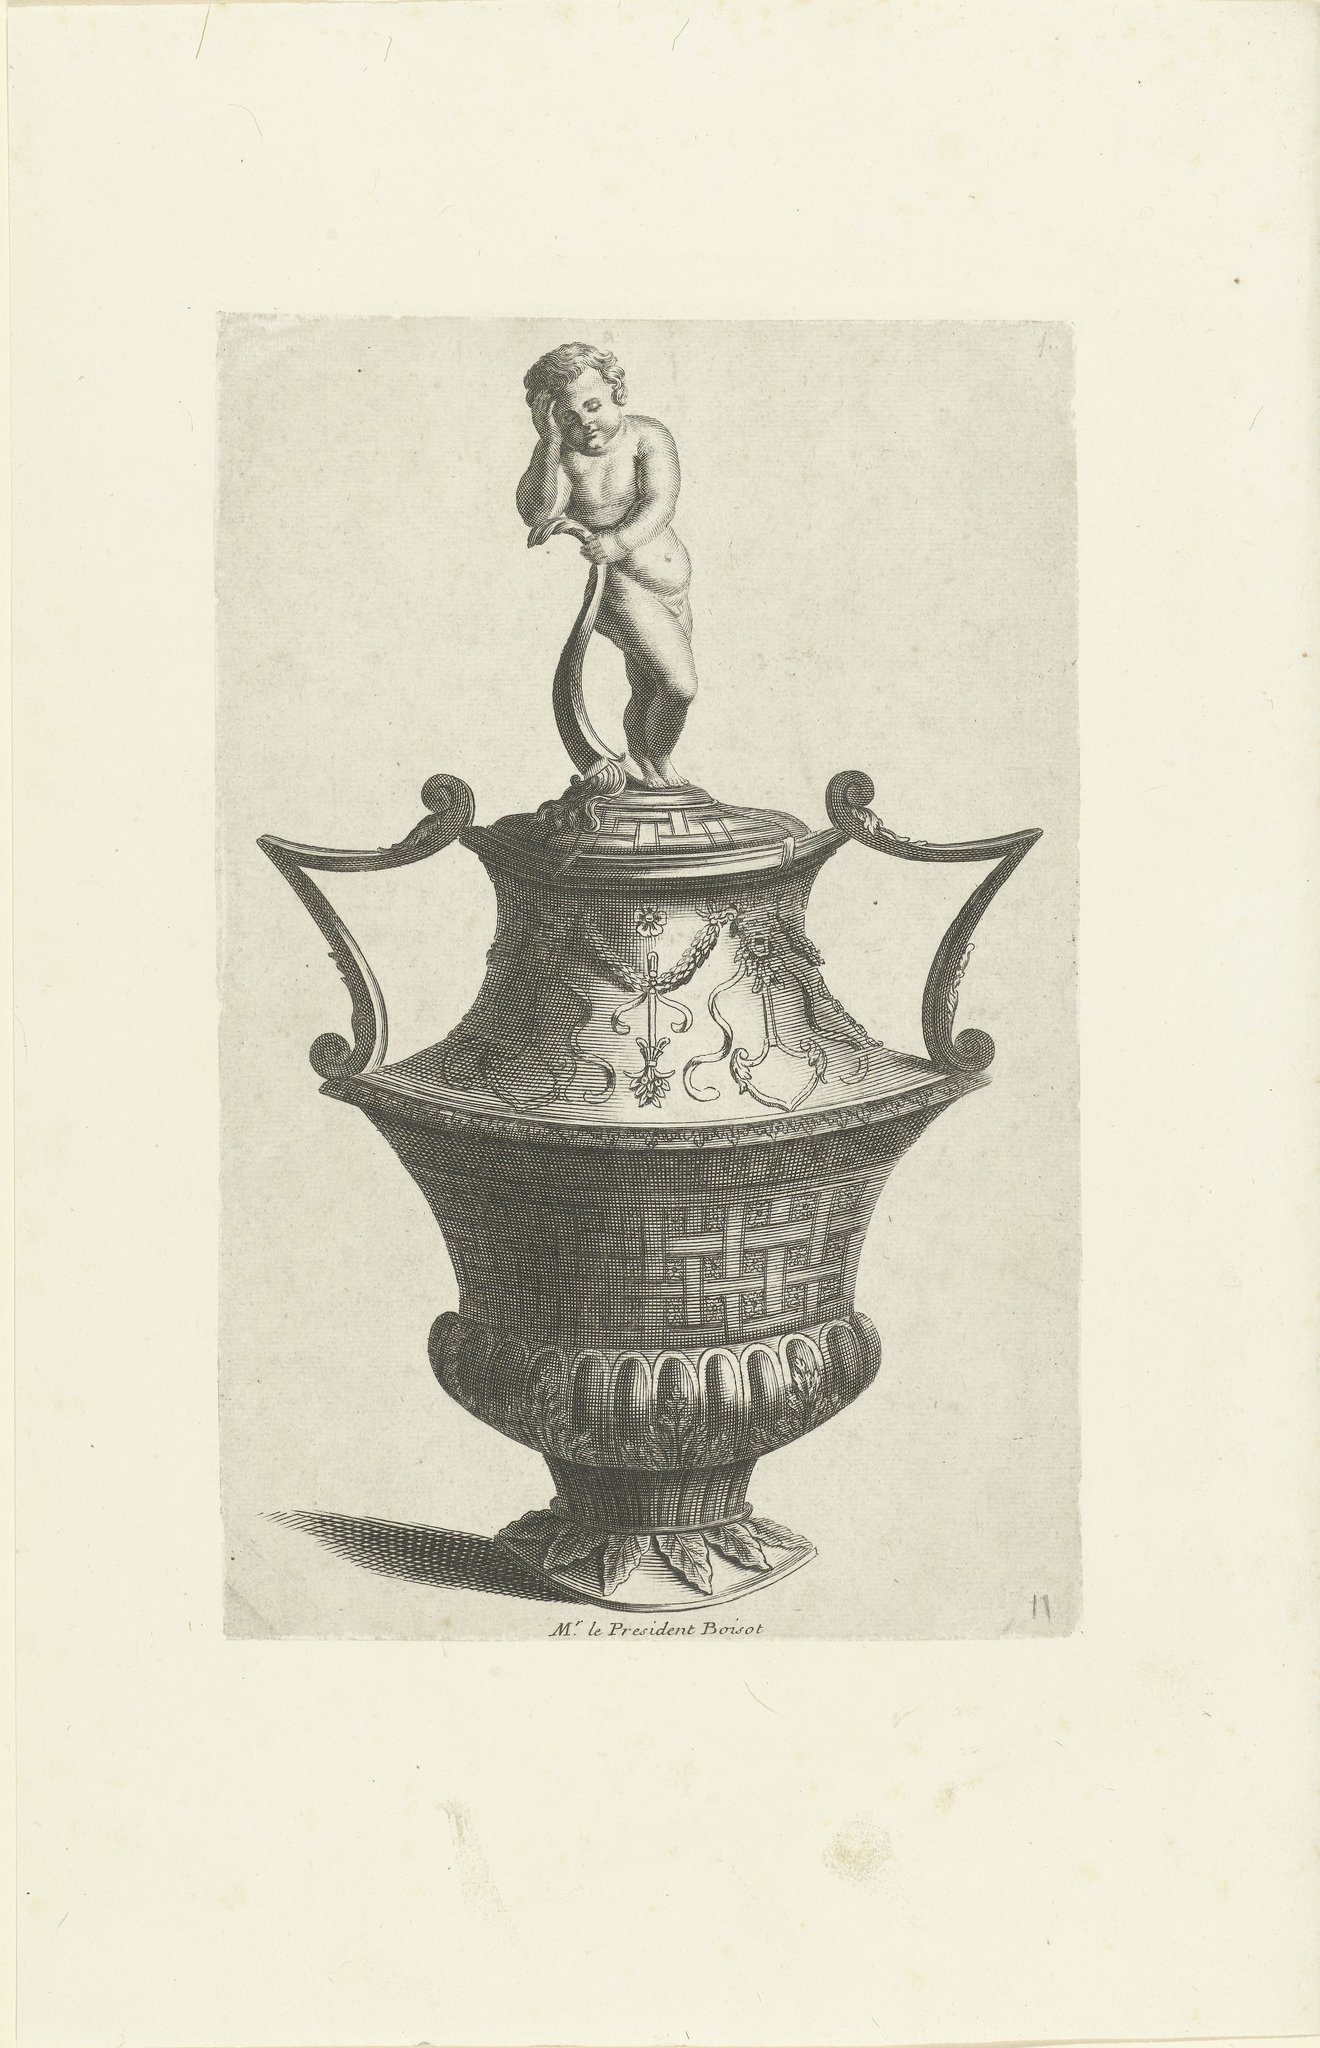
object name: ornament print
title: Vaas met putto op deksel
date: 1606-1657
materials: paper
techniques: engraving, etching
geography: france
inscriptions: number: ‘11’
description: Onderaan staat: Mr. le President Boisot.